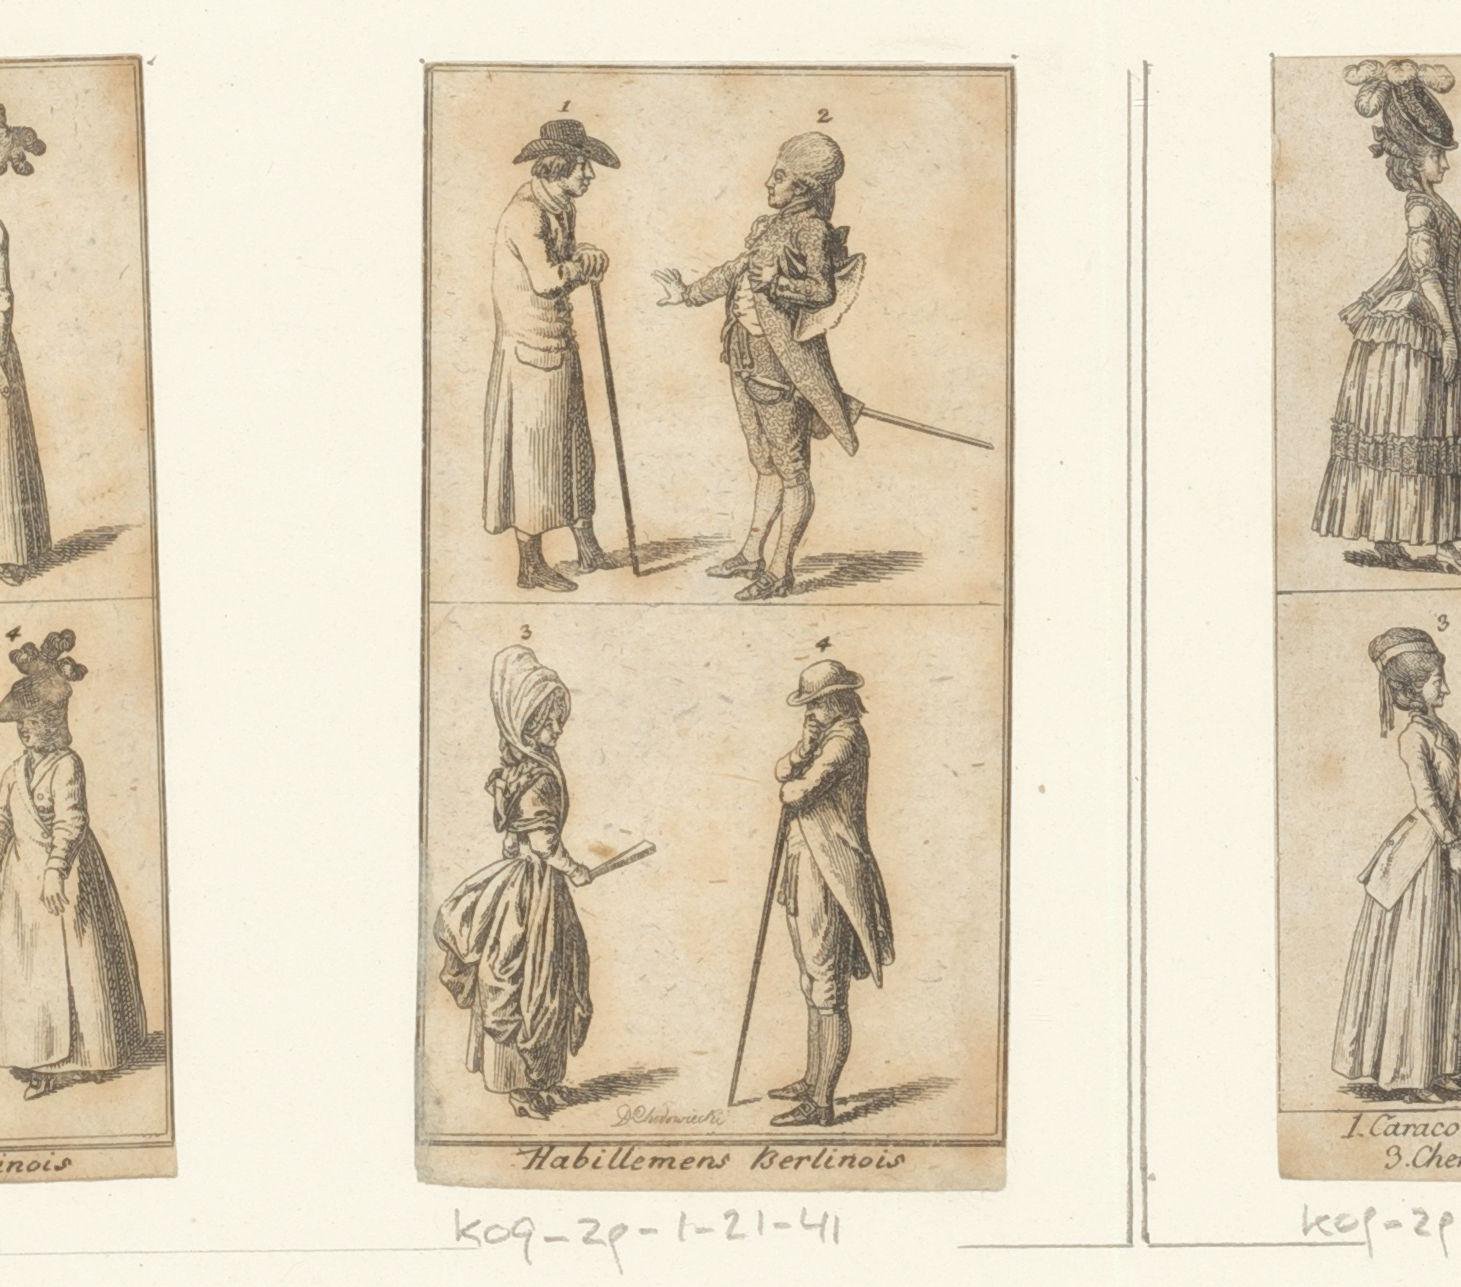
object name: print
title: Drie heren en een dame in Berlijnse mode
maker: daniel nikolaus chodowiecki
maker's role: draughtsman, print maker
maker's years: 1726-1801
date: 1778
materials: paper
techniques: etching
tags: styles of hairdress - aa - ~ women, dress, gown (+ women's clothes), head-gear: hat, historical costume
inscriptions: stamp, collector's mark: Lugt 1641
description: Afbeelding verdeelt in twee vakken. In ieder vak twee dames tegenover elkaar in Berlijnse mode. Onderwerpsrubrieken binnen de Atlas Zeden en Gewoonten: Zeden en Gewoonten in Engeren Zin, De Kleeding, Kleederdrachten (tijdvakken), De 18de eeuw (de pruikentijd). Mannen en vrouwen.